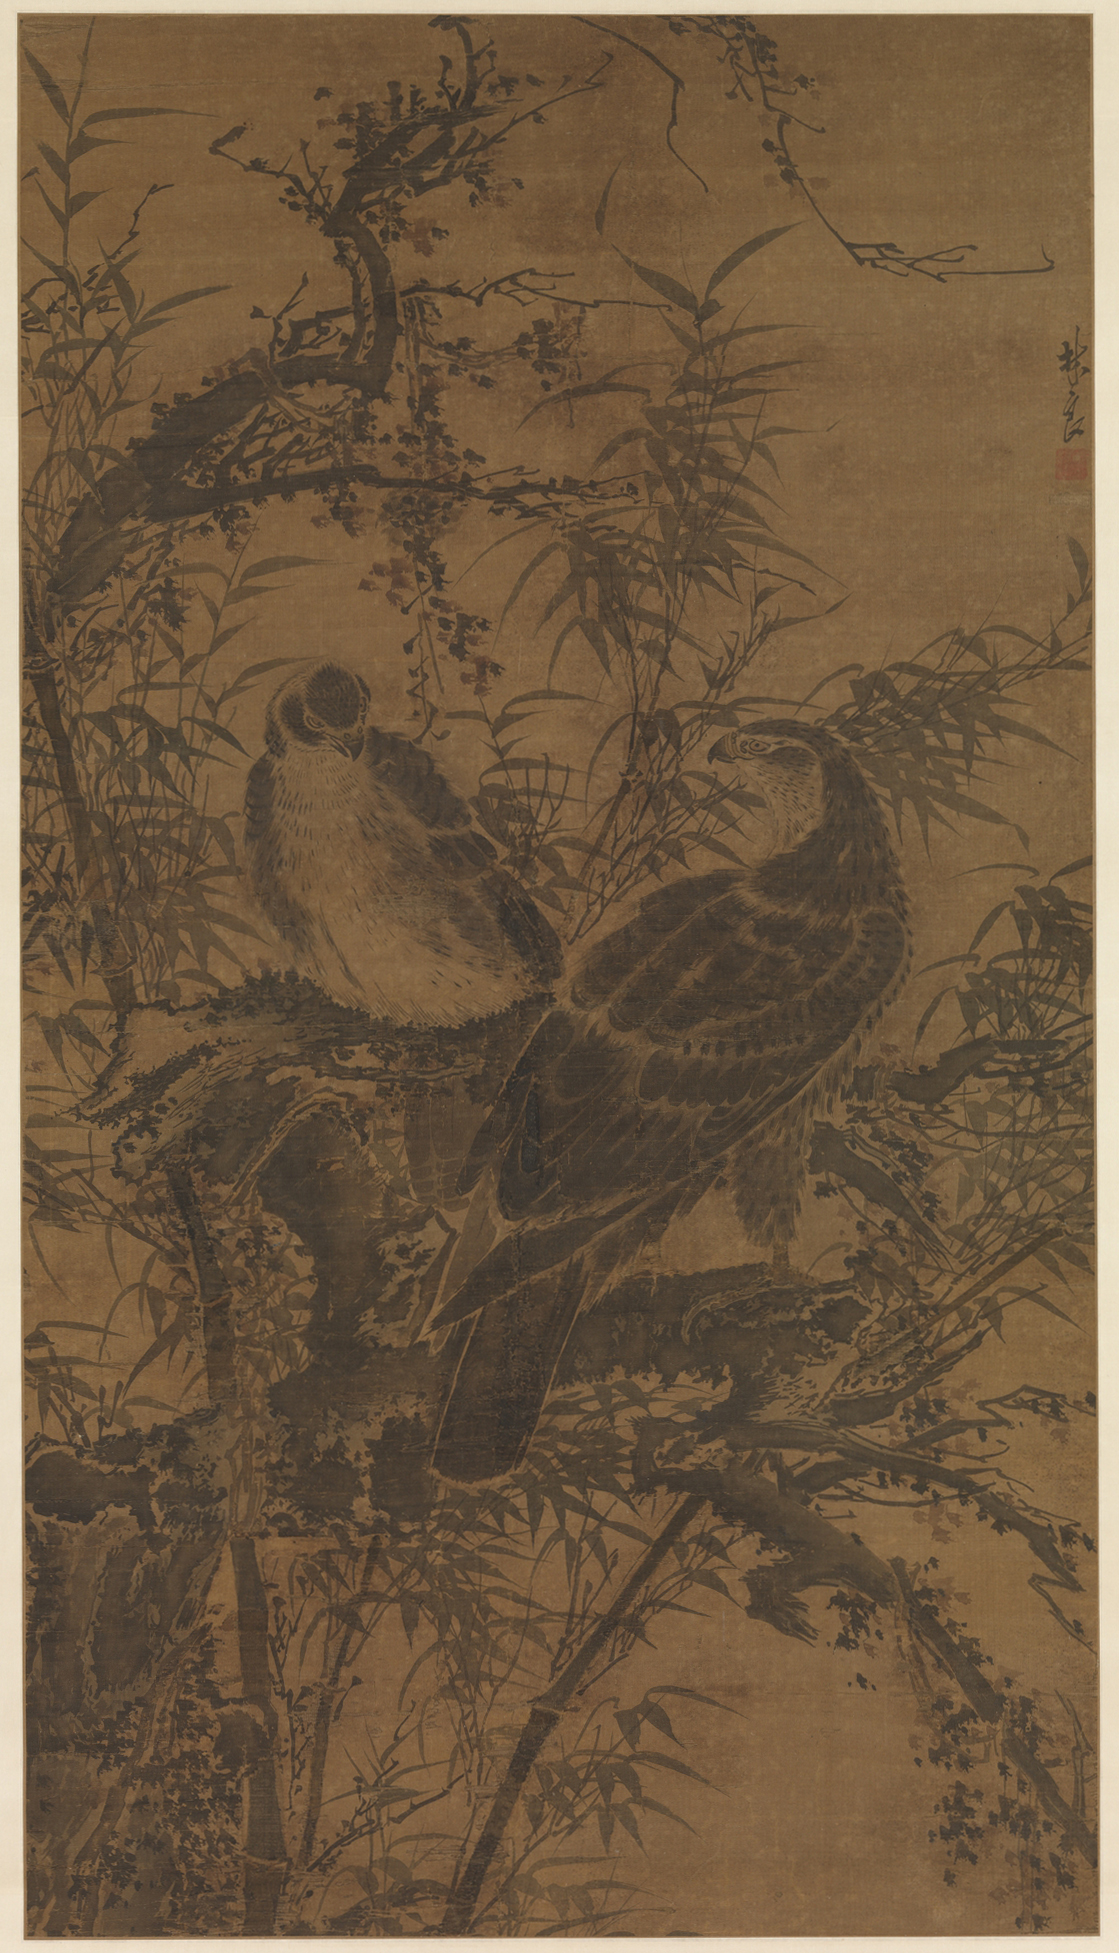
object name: hanging scroll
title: Two hawks in a thicket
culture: chinese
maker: lin liang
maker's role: artist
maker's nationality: chinese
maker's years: 1416-1480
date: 1434-1466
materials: ink, silk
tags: hawks